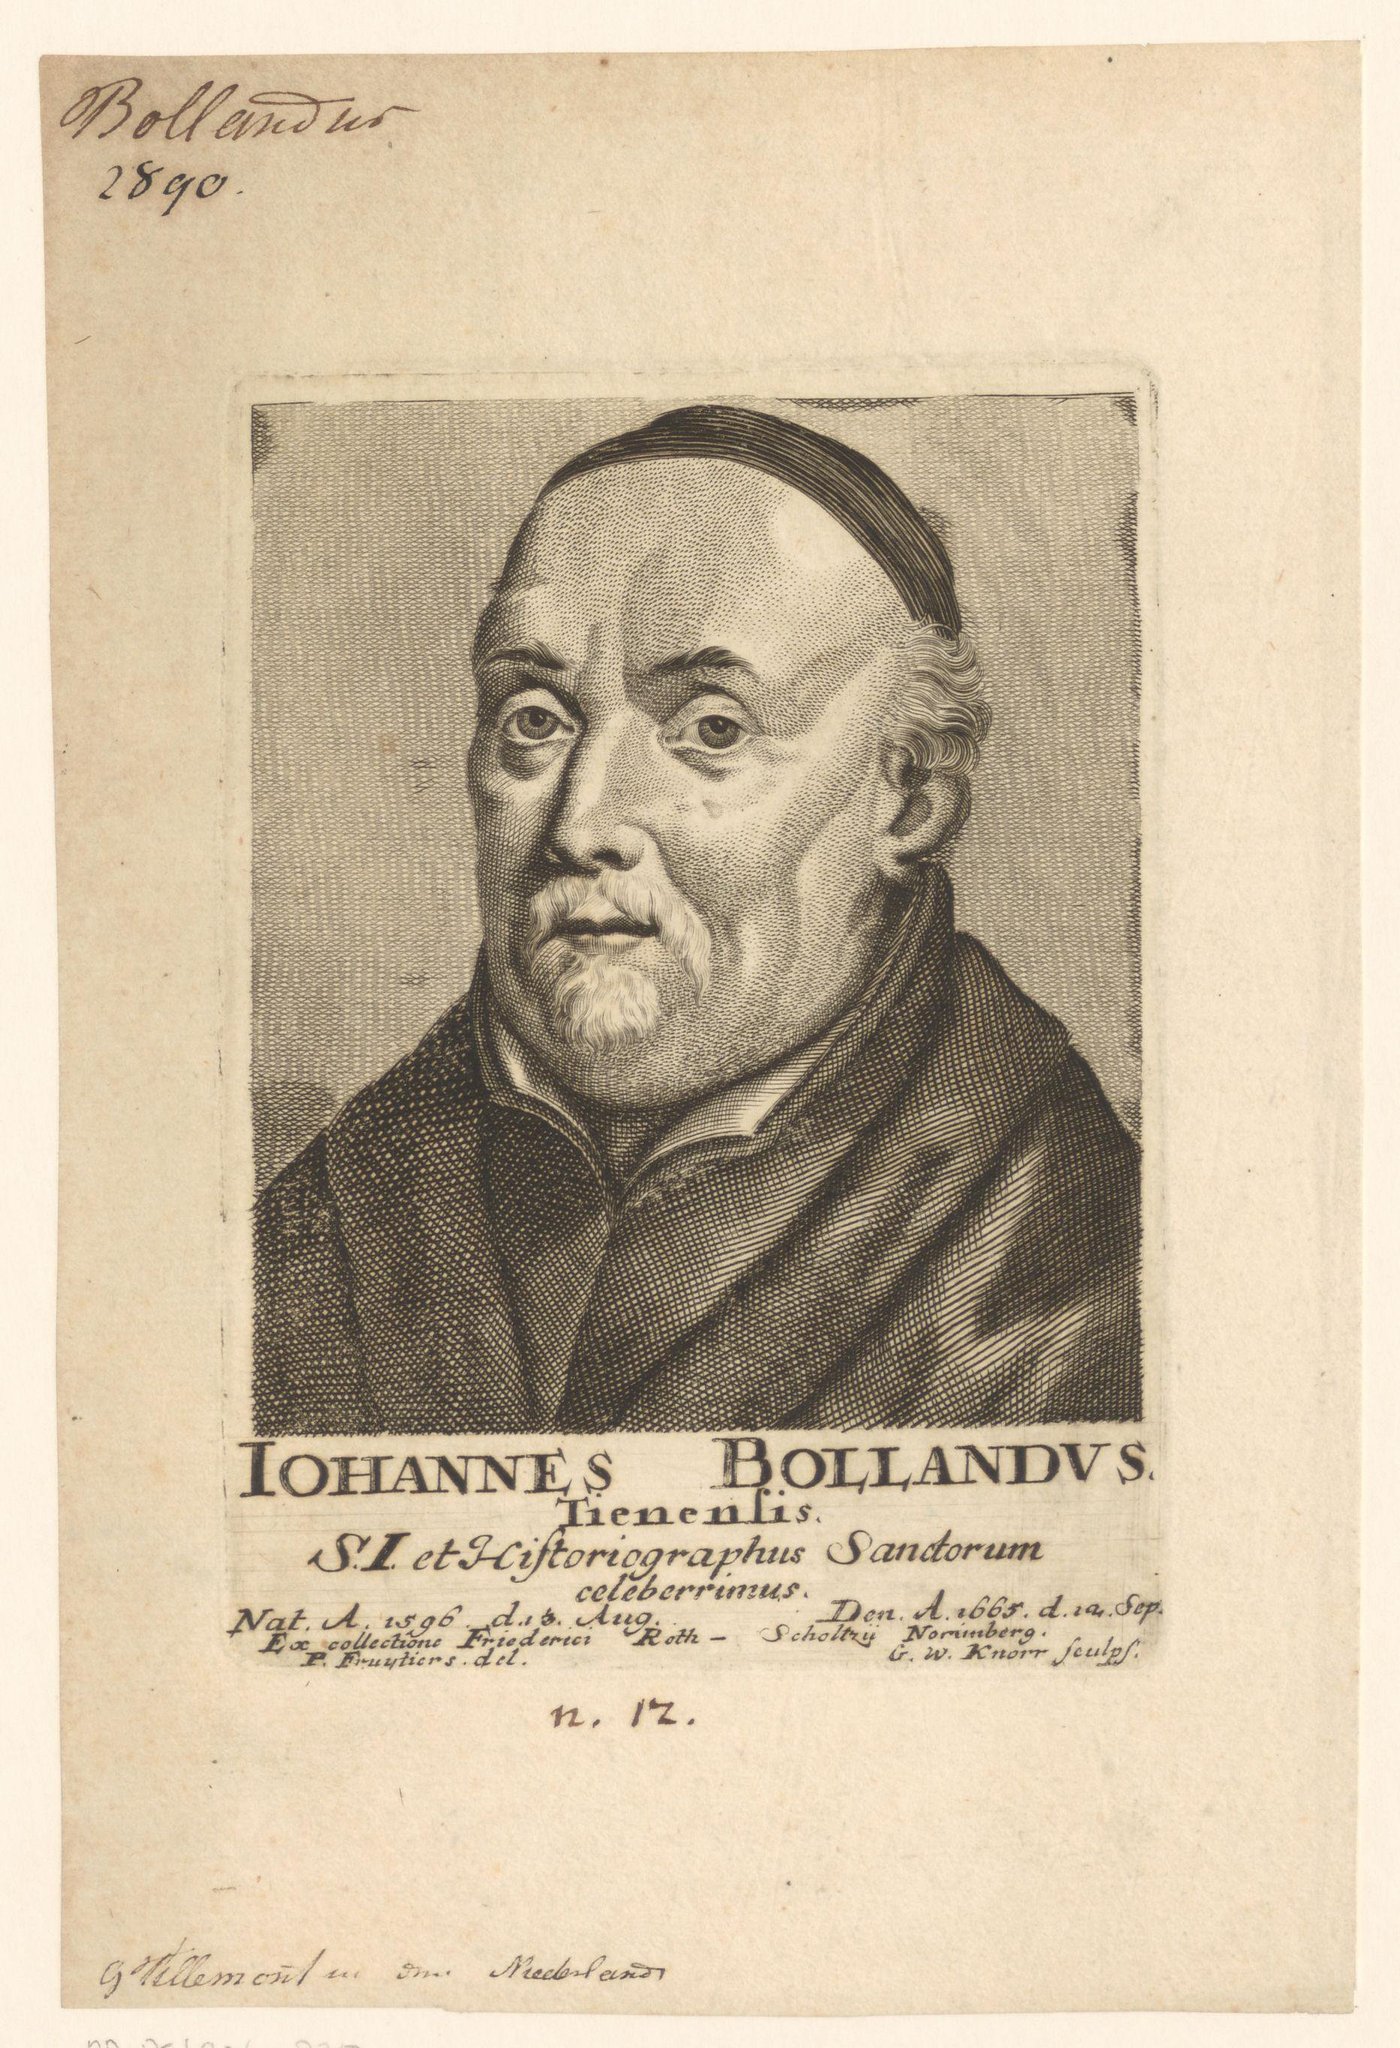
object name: print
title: Portret van Johannes Bolland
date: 1715-1761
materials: paper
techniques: engraving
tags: antwerp, theologian, historical persons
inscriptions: annotation: ‘n. 12’, annotation: ‘Bollandius 2890.’, annotation: ‘G. Willem ont in den Niederland’, collector's mark: Lugt 2228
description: Deze prent komt uit de collectie van Friedrich Roth-Scholtz (1687-1736) uit Neurenberg.